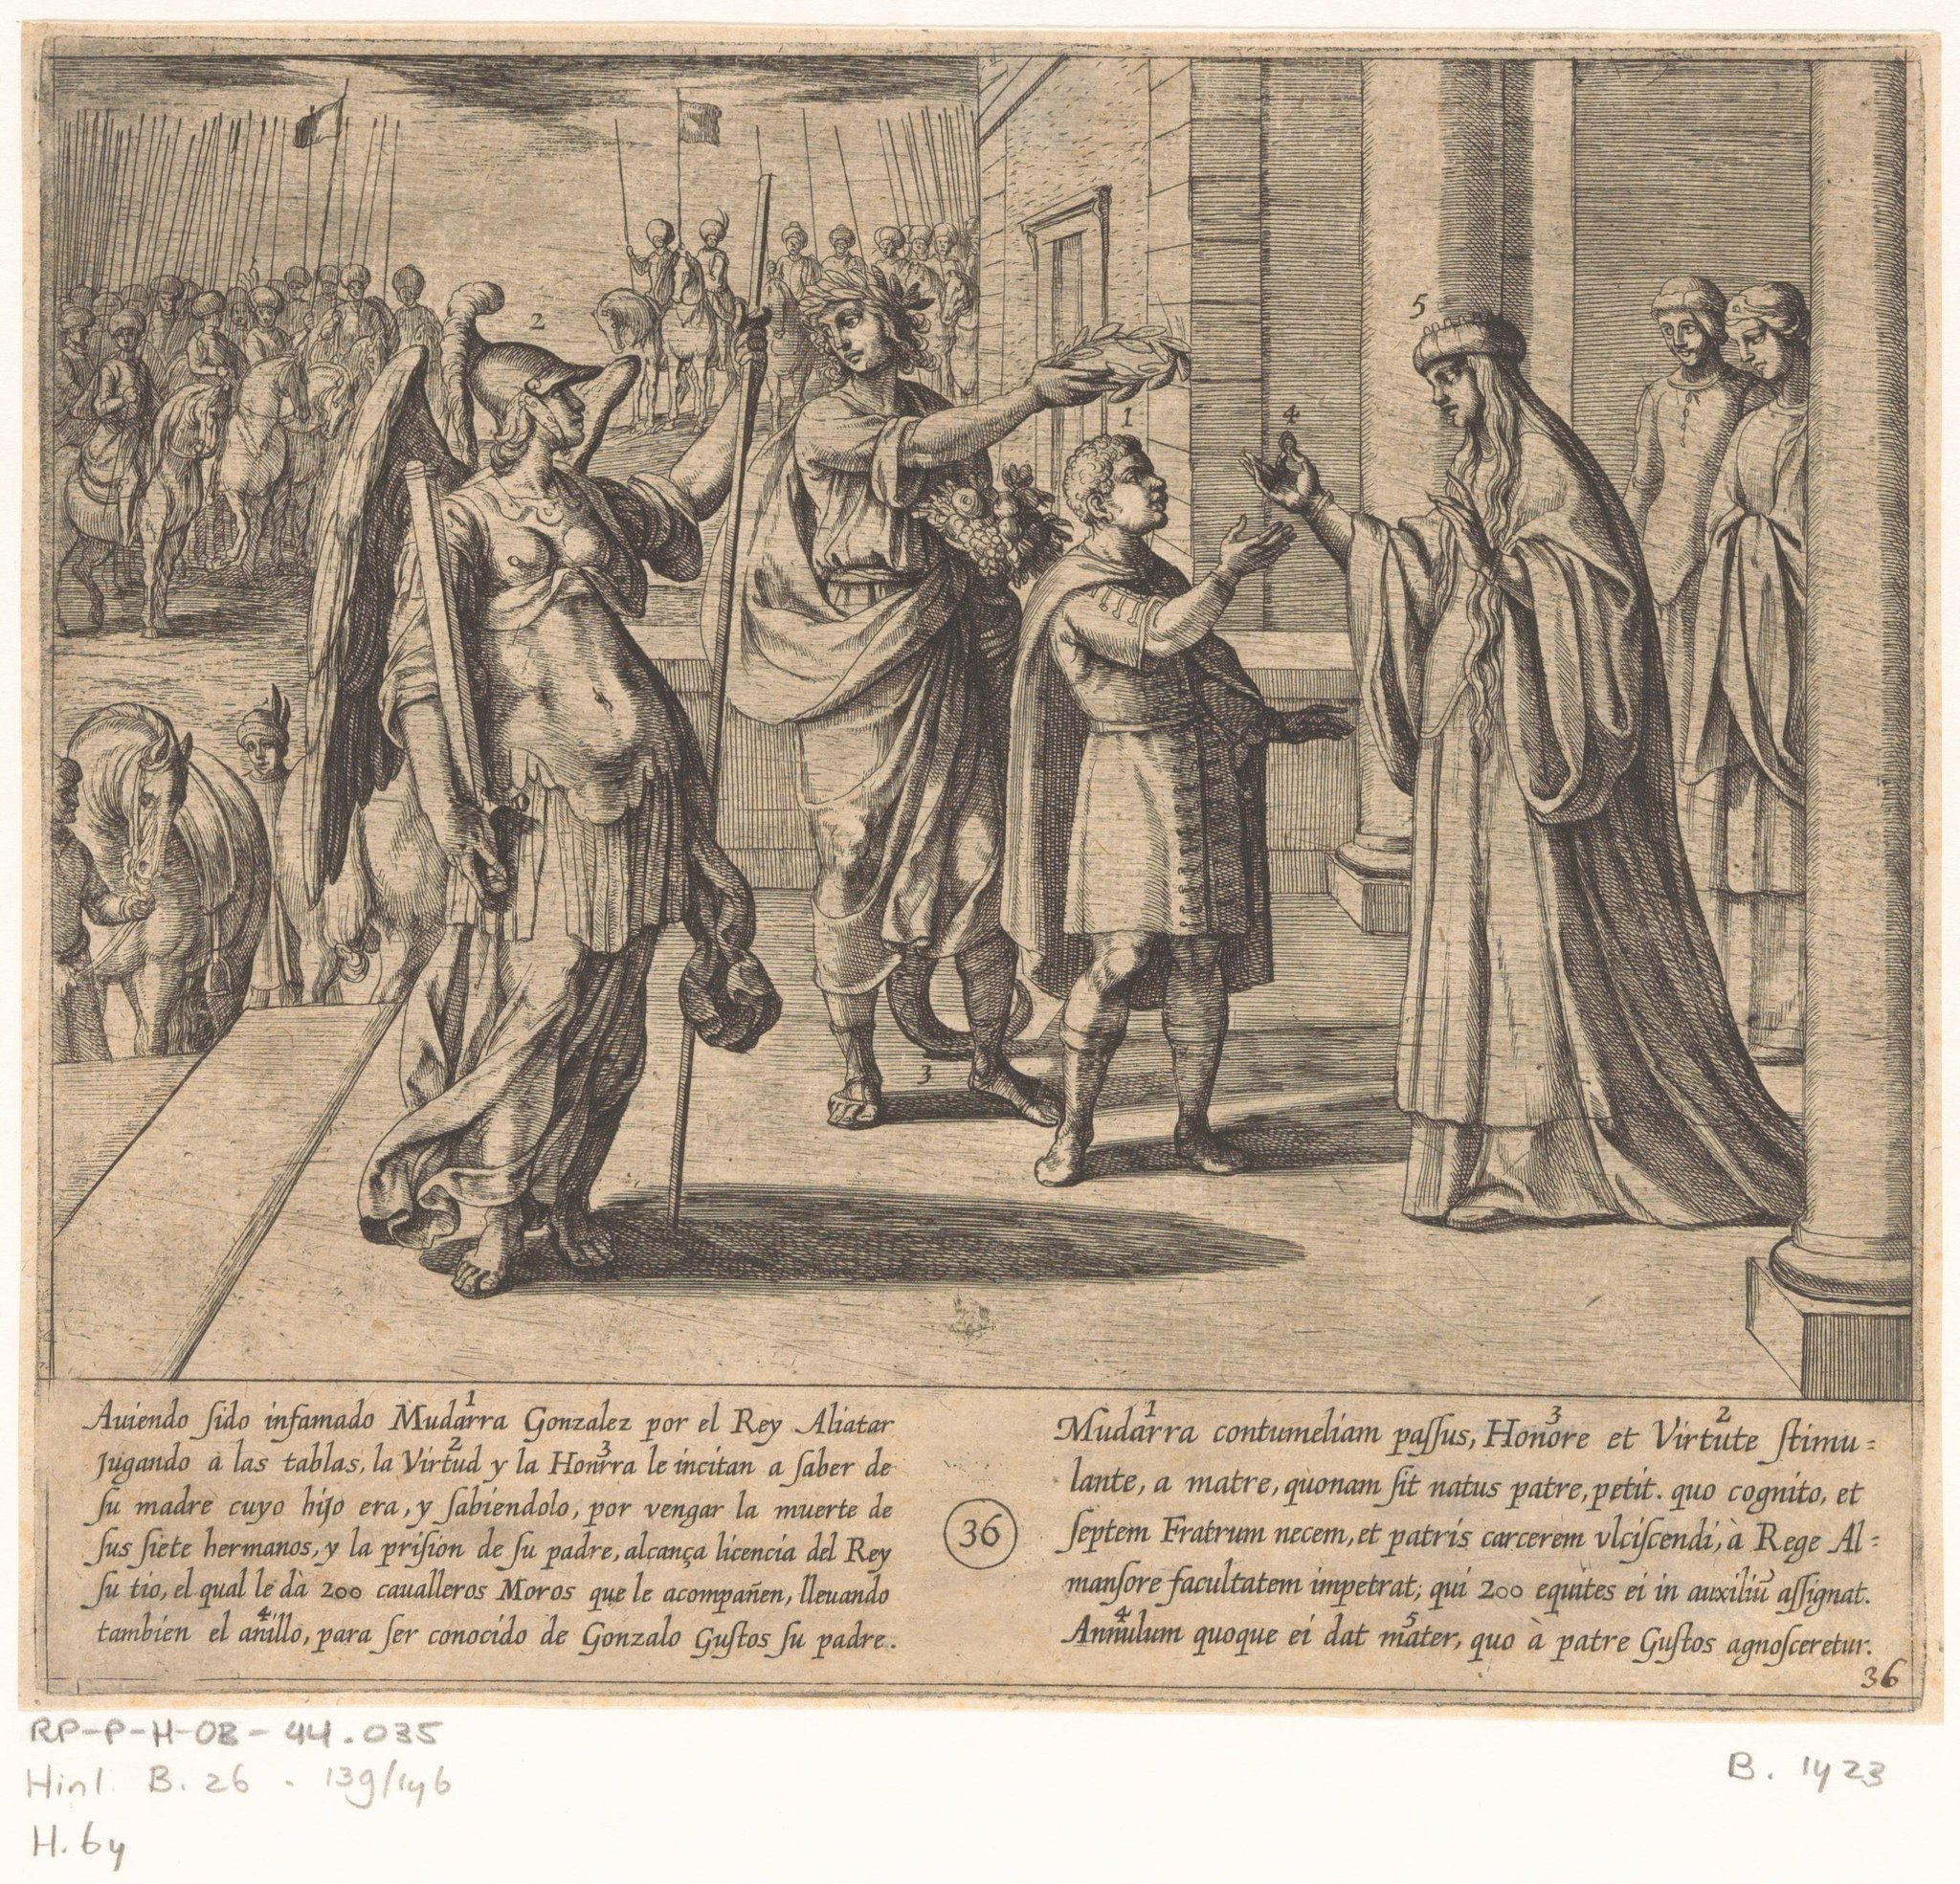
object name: print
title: Historia Septem Infantium de Lara/ Historia de los Siete Infantes de Lara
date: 1612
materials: paper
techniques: etching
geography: antwerp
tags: warfare; military affairs (+ cavalry, horsemen), tales and fairy tales, crowning with laurel, waving farewell ~ departure on a journey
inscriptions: collector's mark: Lugt 11, number: ‘36’, collector's mark: ‘Hinloopen’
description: Deze prent maakt deel uit van een reeks van 40 prenten (+ titelprent) met voorstellingen uit het volksverhaal over de zeven infanten van Lara.